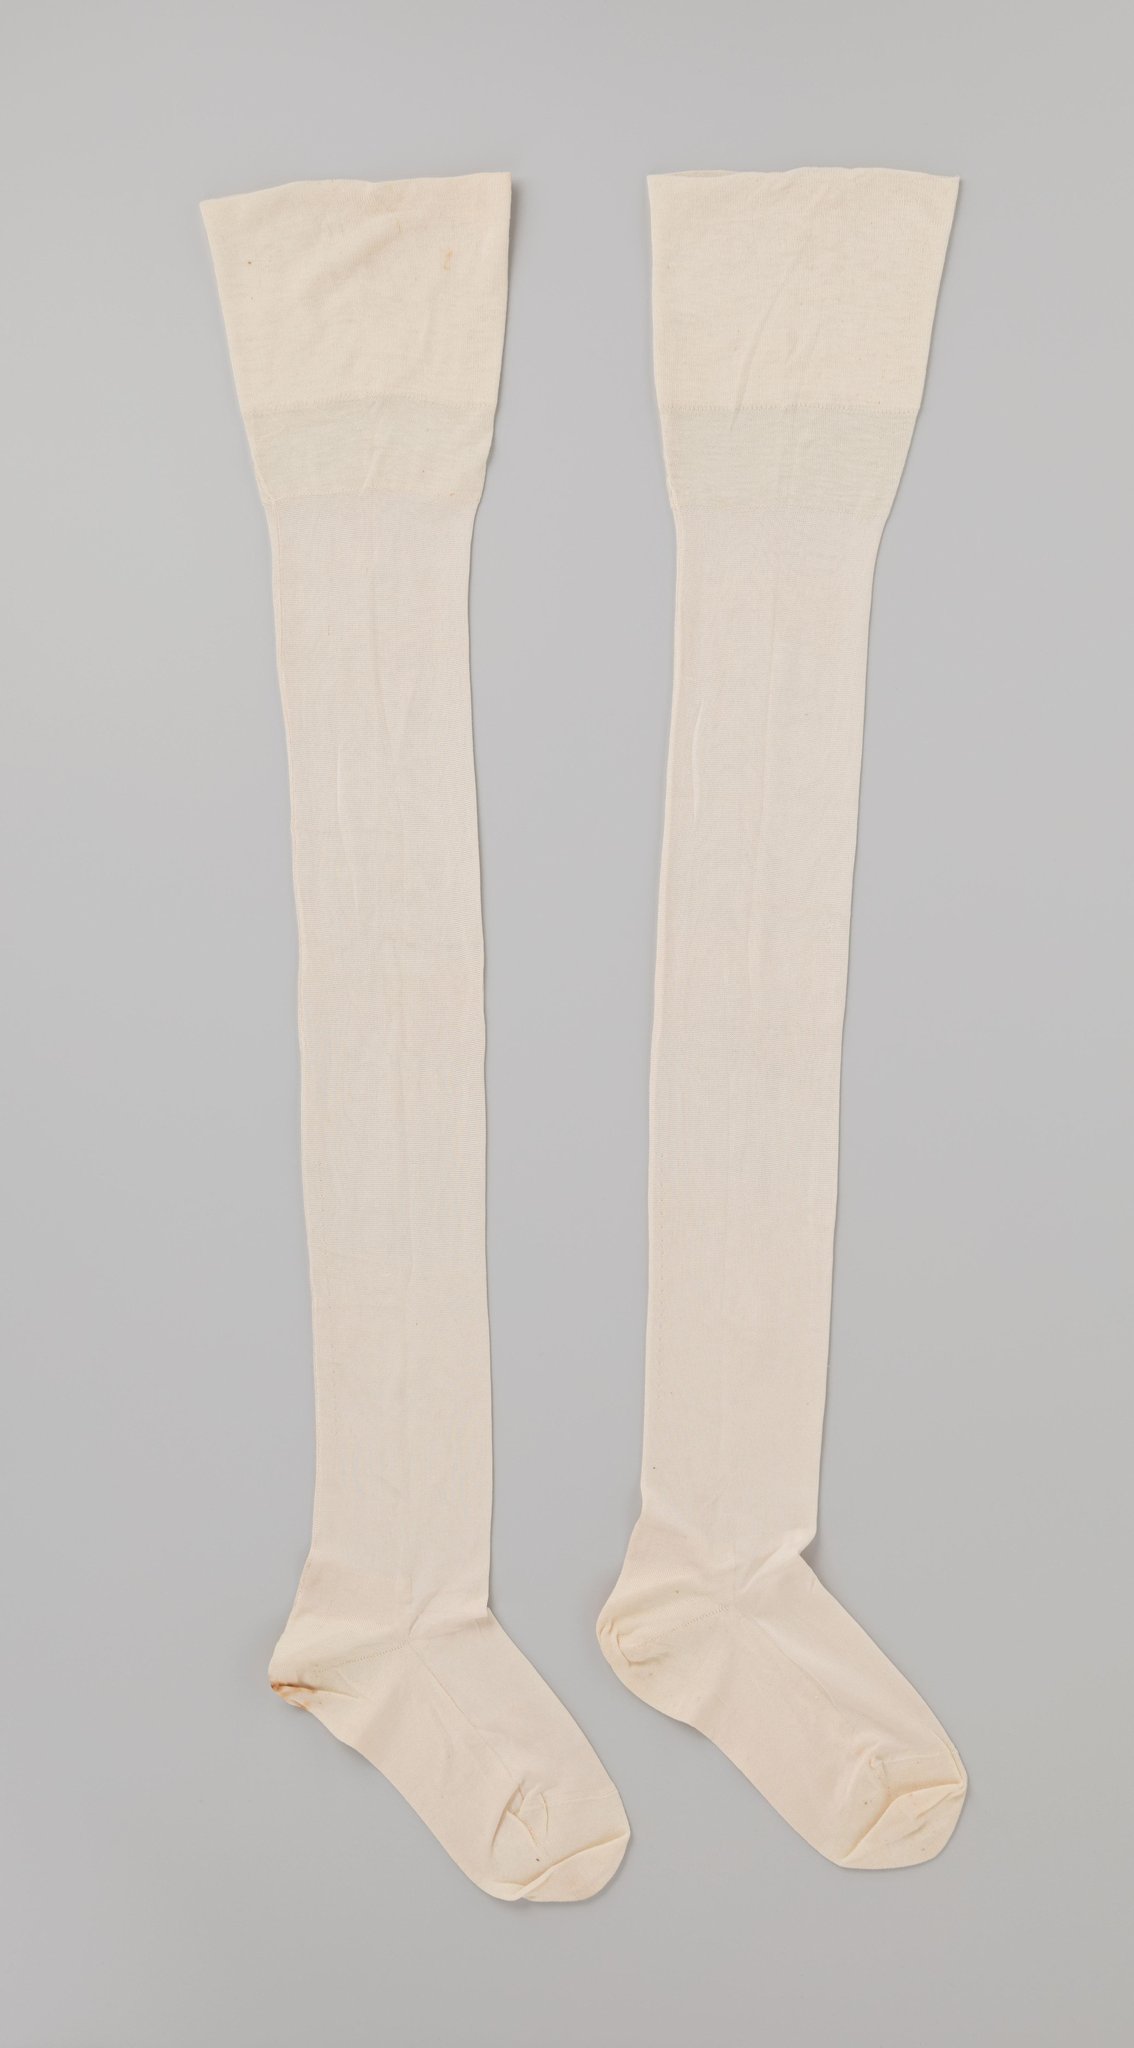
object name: stocking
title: Kous gebreid van witte zijde met brede katoenen boord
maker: Anonymous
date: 1910-1920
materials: cotton, silk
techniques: knitting, printing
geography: lille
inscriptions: size: ‘'8 1/2'’, address: ‘'SILK LISLE'’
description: Kous van witte zijde. Model: met naad. Boord van katoen. Vierkante hiel. Gedrukt onder de voet: SILK LISLE. Op de teen: 8 1/2. Bruine vlekken op de hiel.